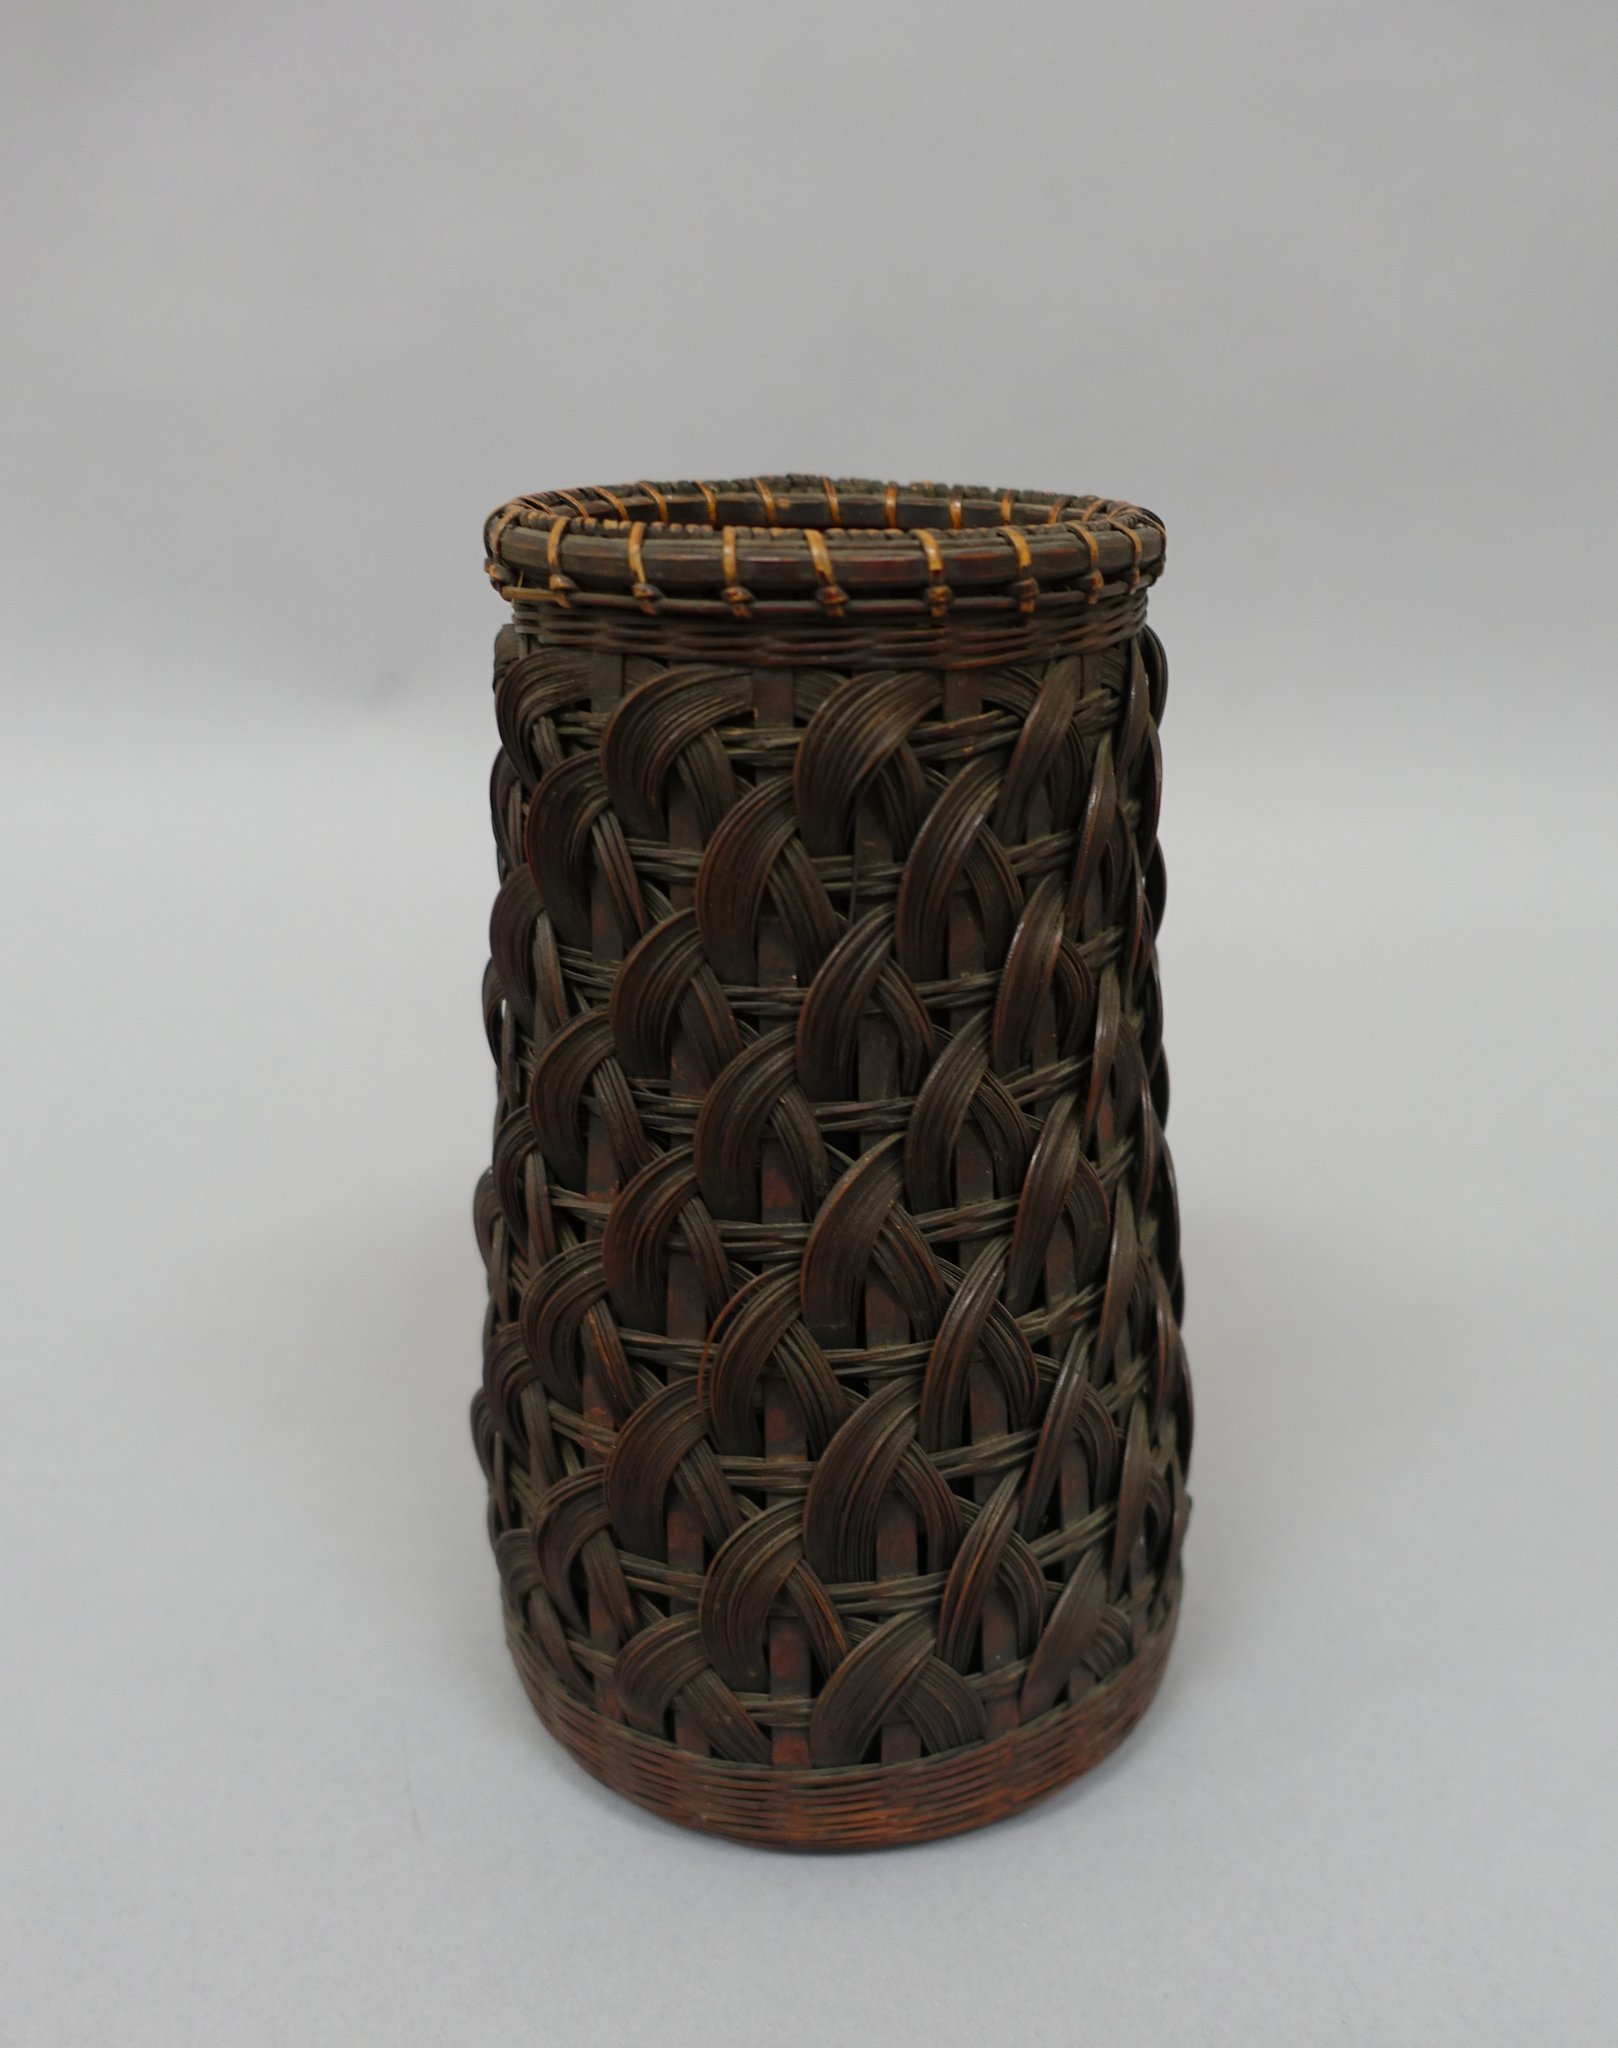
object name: basket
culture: japanese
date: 1801-1900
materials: rattan